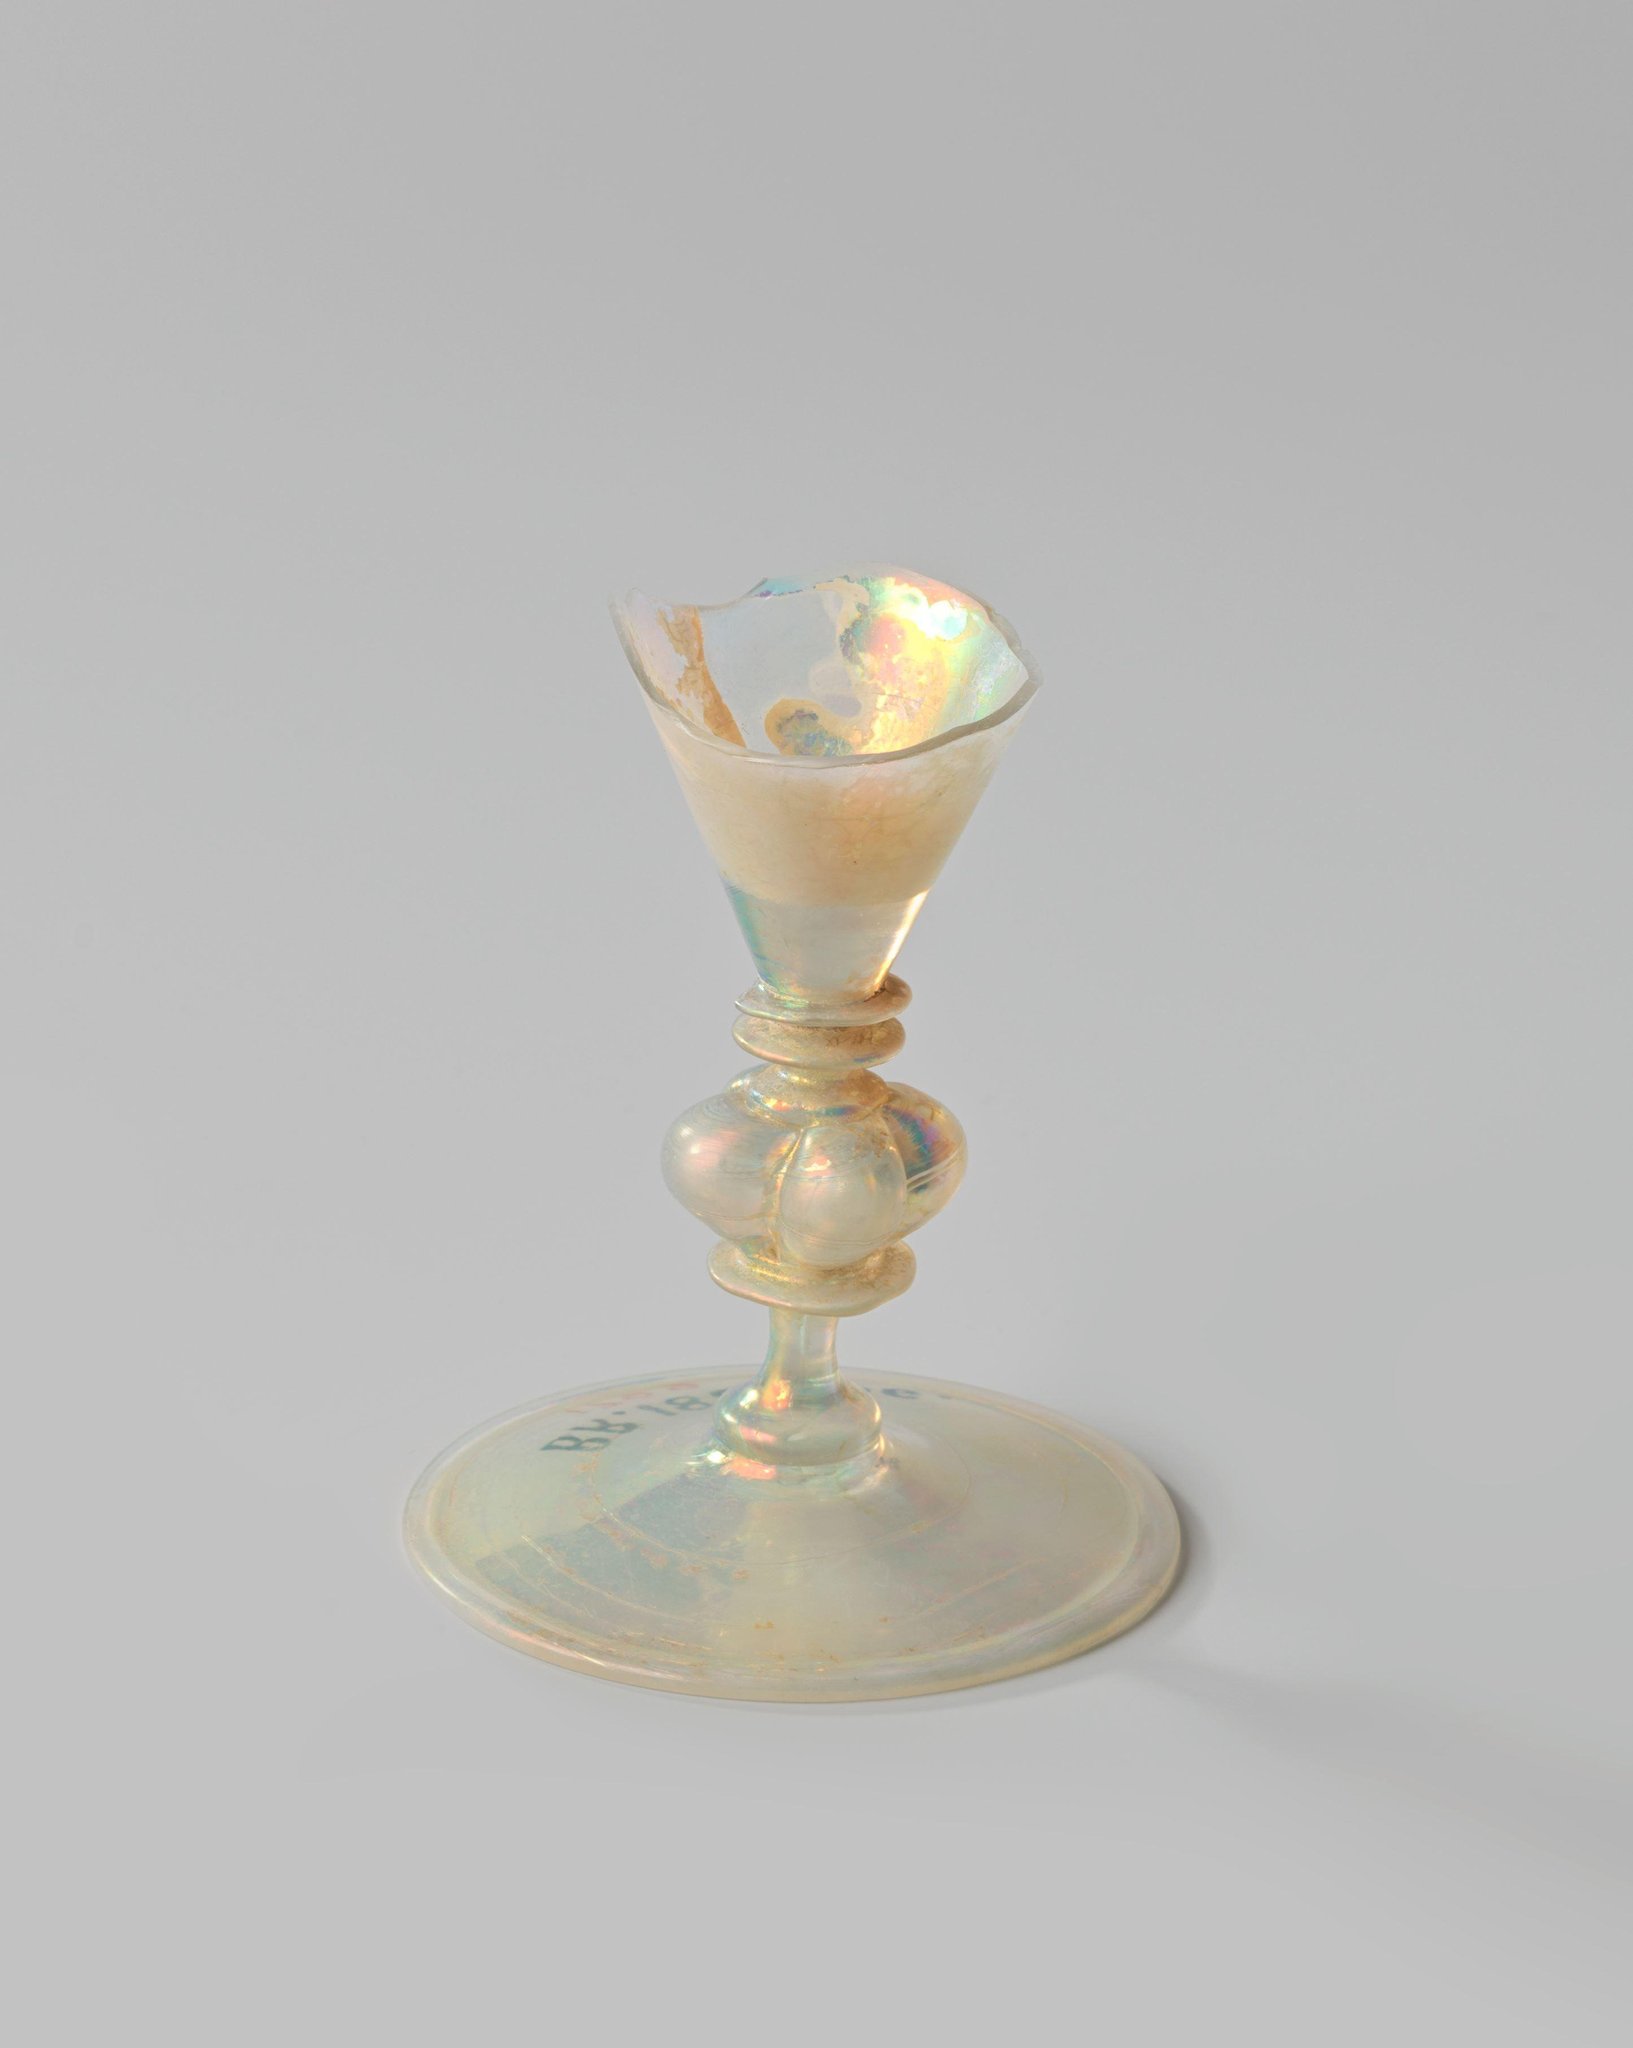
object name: fragment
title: Voet, stam en deel van de kelk van een kelkglas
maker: Anonymous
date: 1650-1700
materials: glass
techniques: façon de venise, glassblowing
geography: low countries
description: Platte voet met omgeslagen rand. De stam opgebouwd uit een holle, vierlobbige baluster en drie schijven. Er mist een deel van de trechtervormige kelk. Bodemvondst.